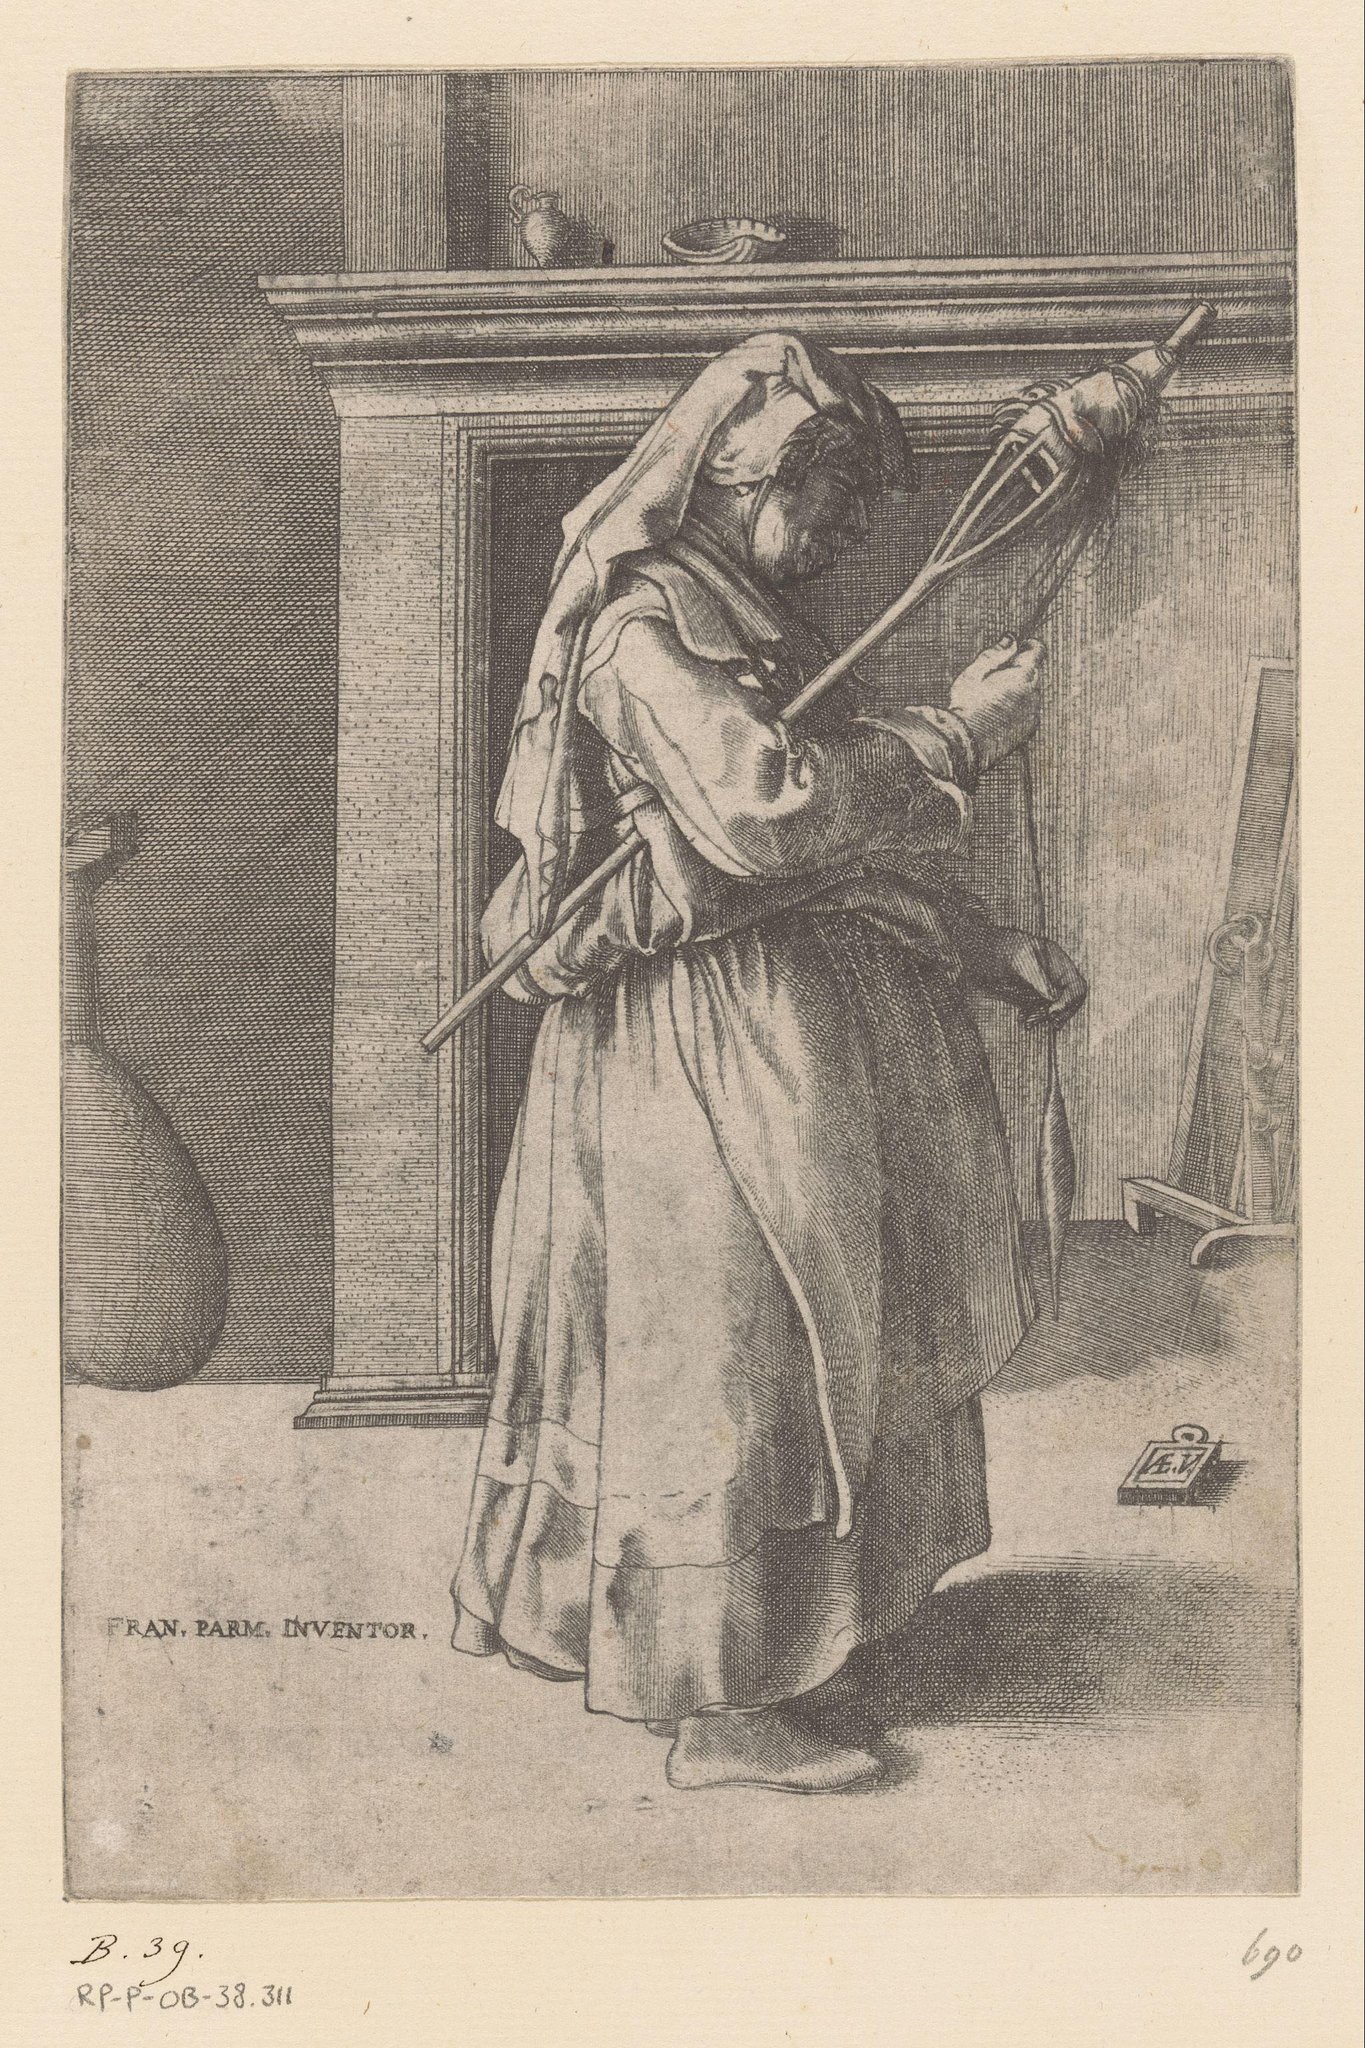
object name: print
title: Oudere vrouw met spinrok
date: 1533-1567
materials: paper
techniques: engraving, intaglio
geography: italy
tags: distaff, old woman, lute, and special forms of lute, e.g.: theorbo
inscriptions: collector's mark: Lugt 240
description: Een oudere vrouw, staand in een interieur met een spinrok onder de arm. Links leunt tegen de muur een kist van een luit.